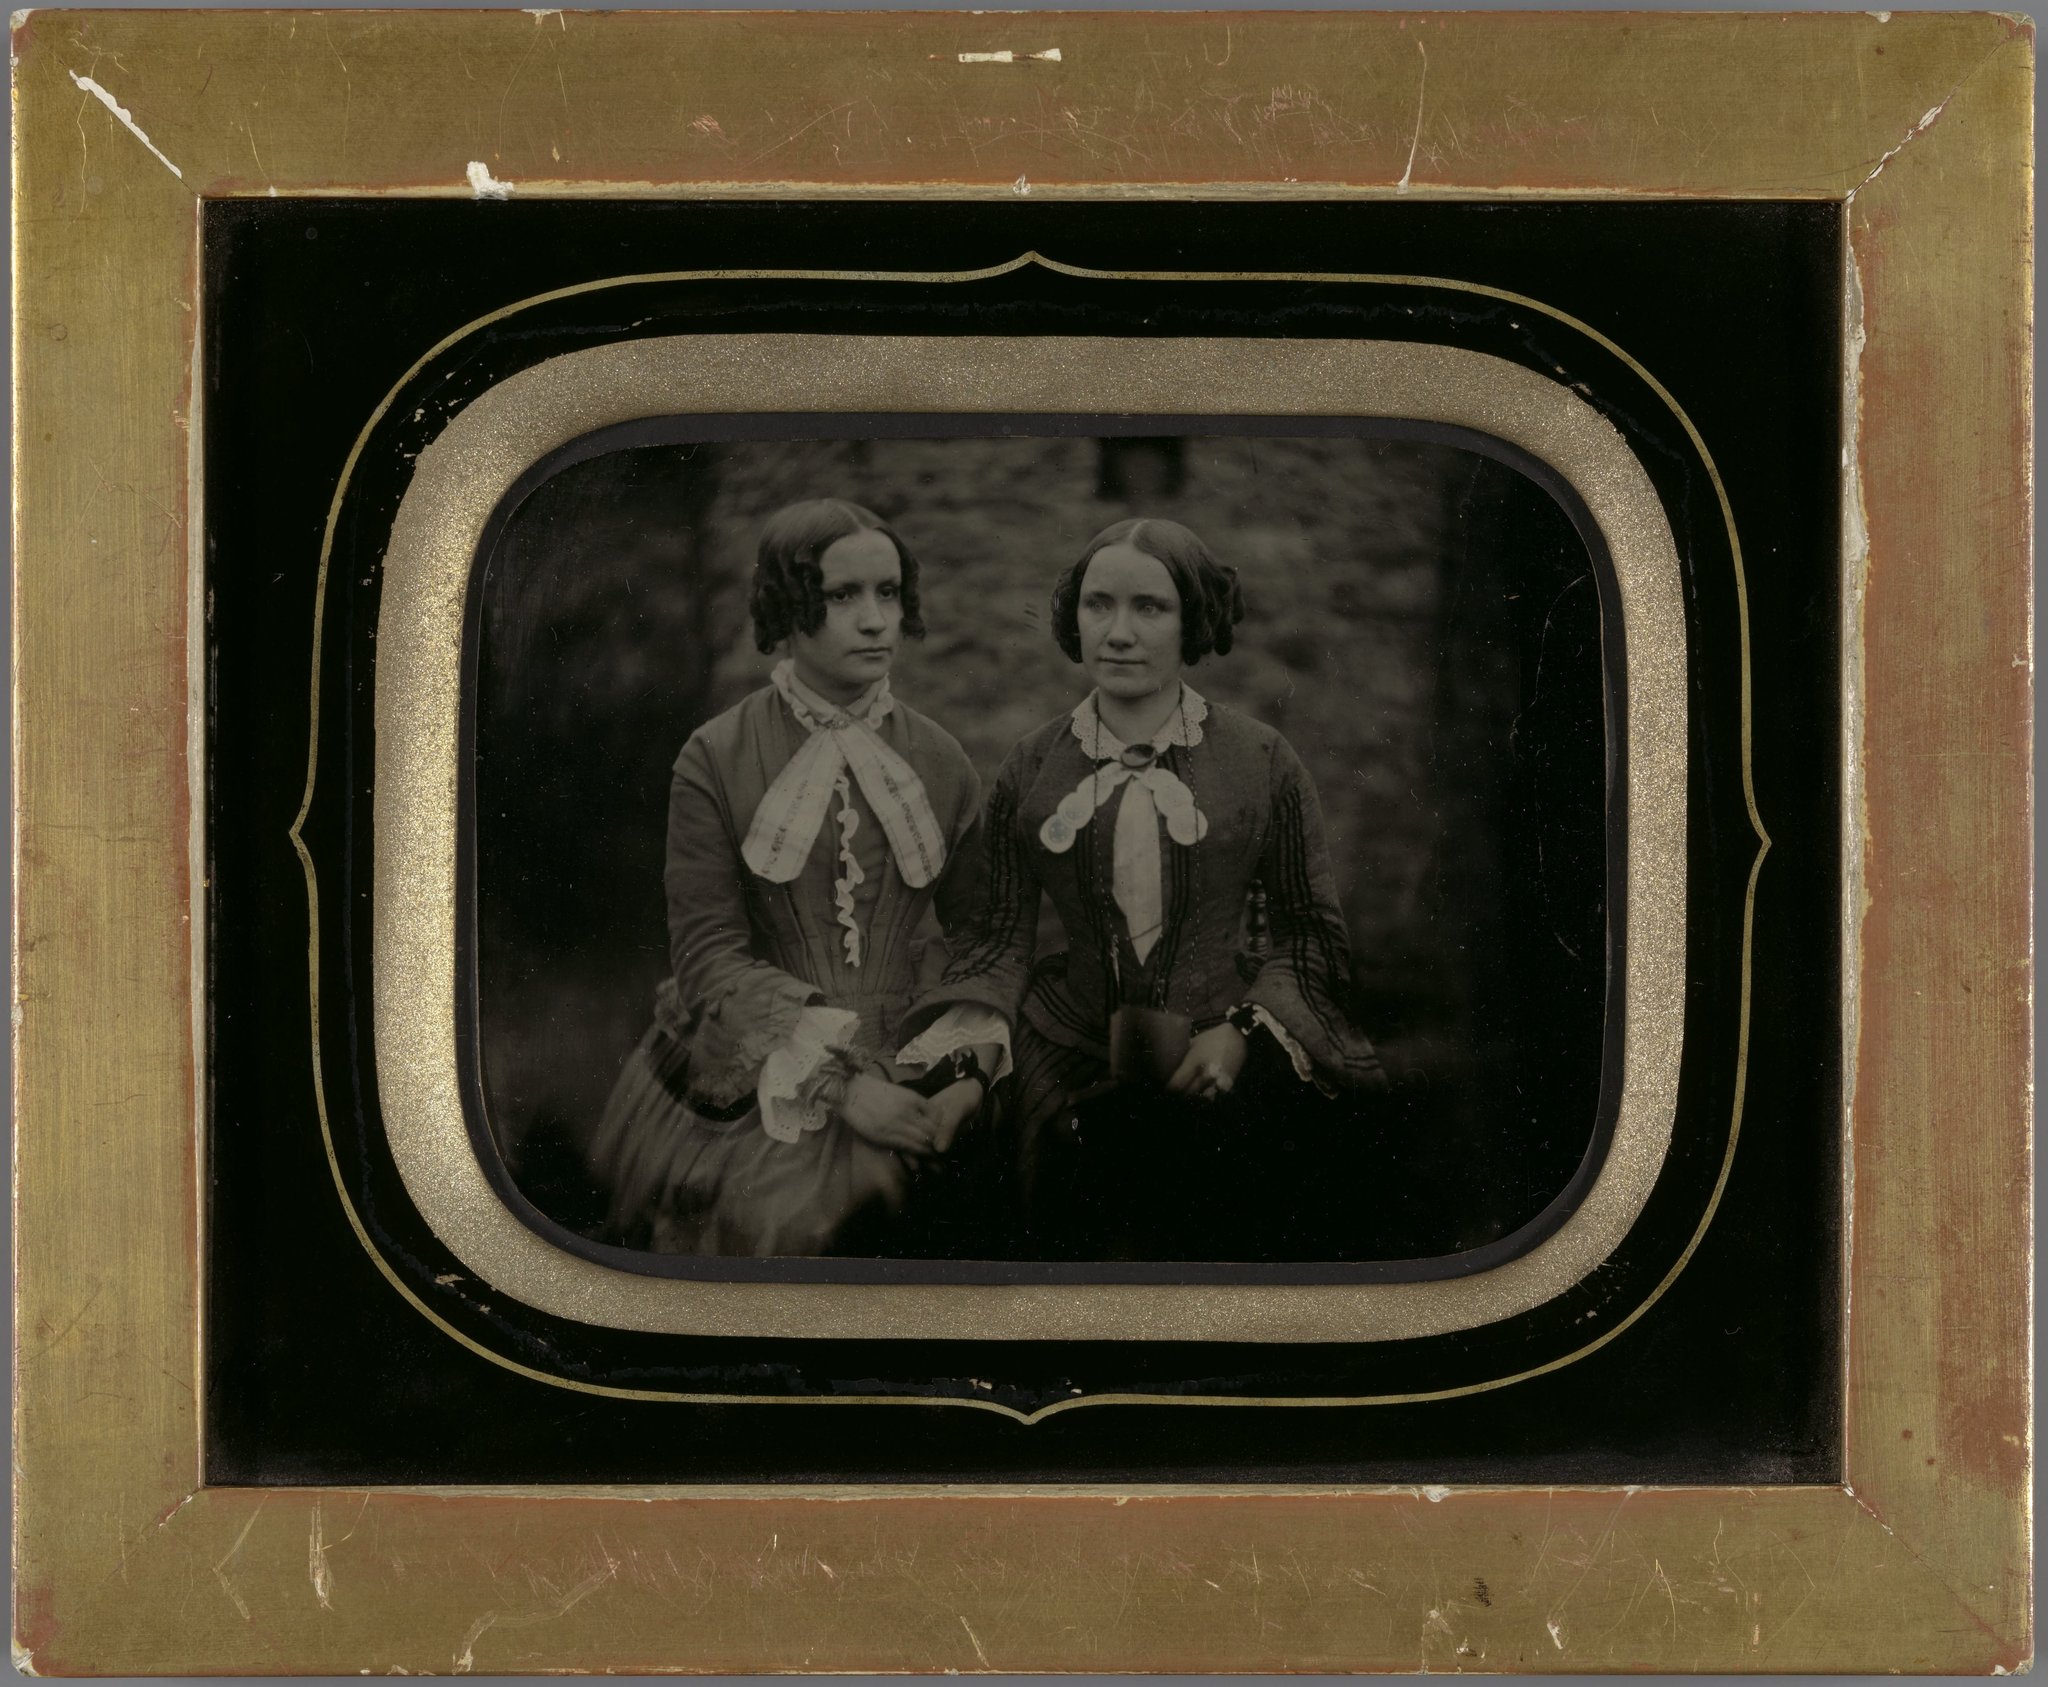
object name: photograph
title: Portret van twee vrouwen in lijst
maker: Anonymous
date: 1855-1875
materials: glass, gypsum, paper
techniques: ambrotype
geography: netherlands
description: Naast elkaar zittend, elkaars hand vasthoudend.